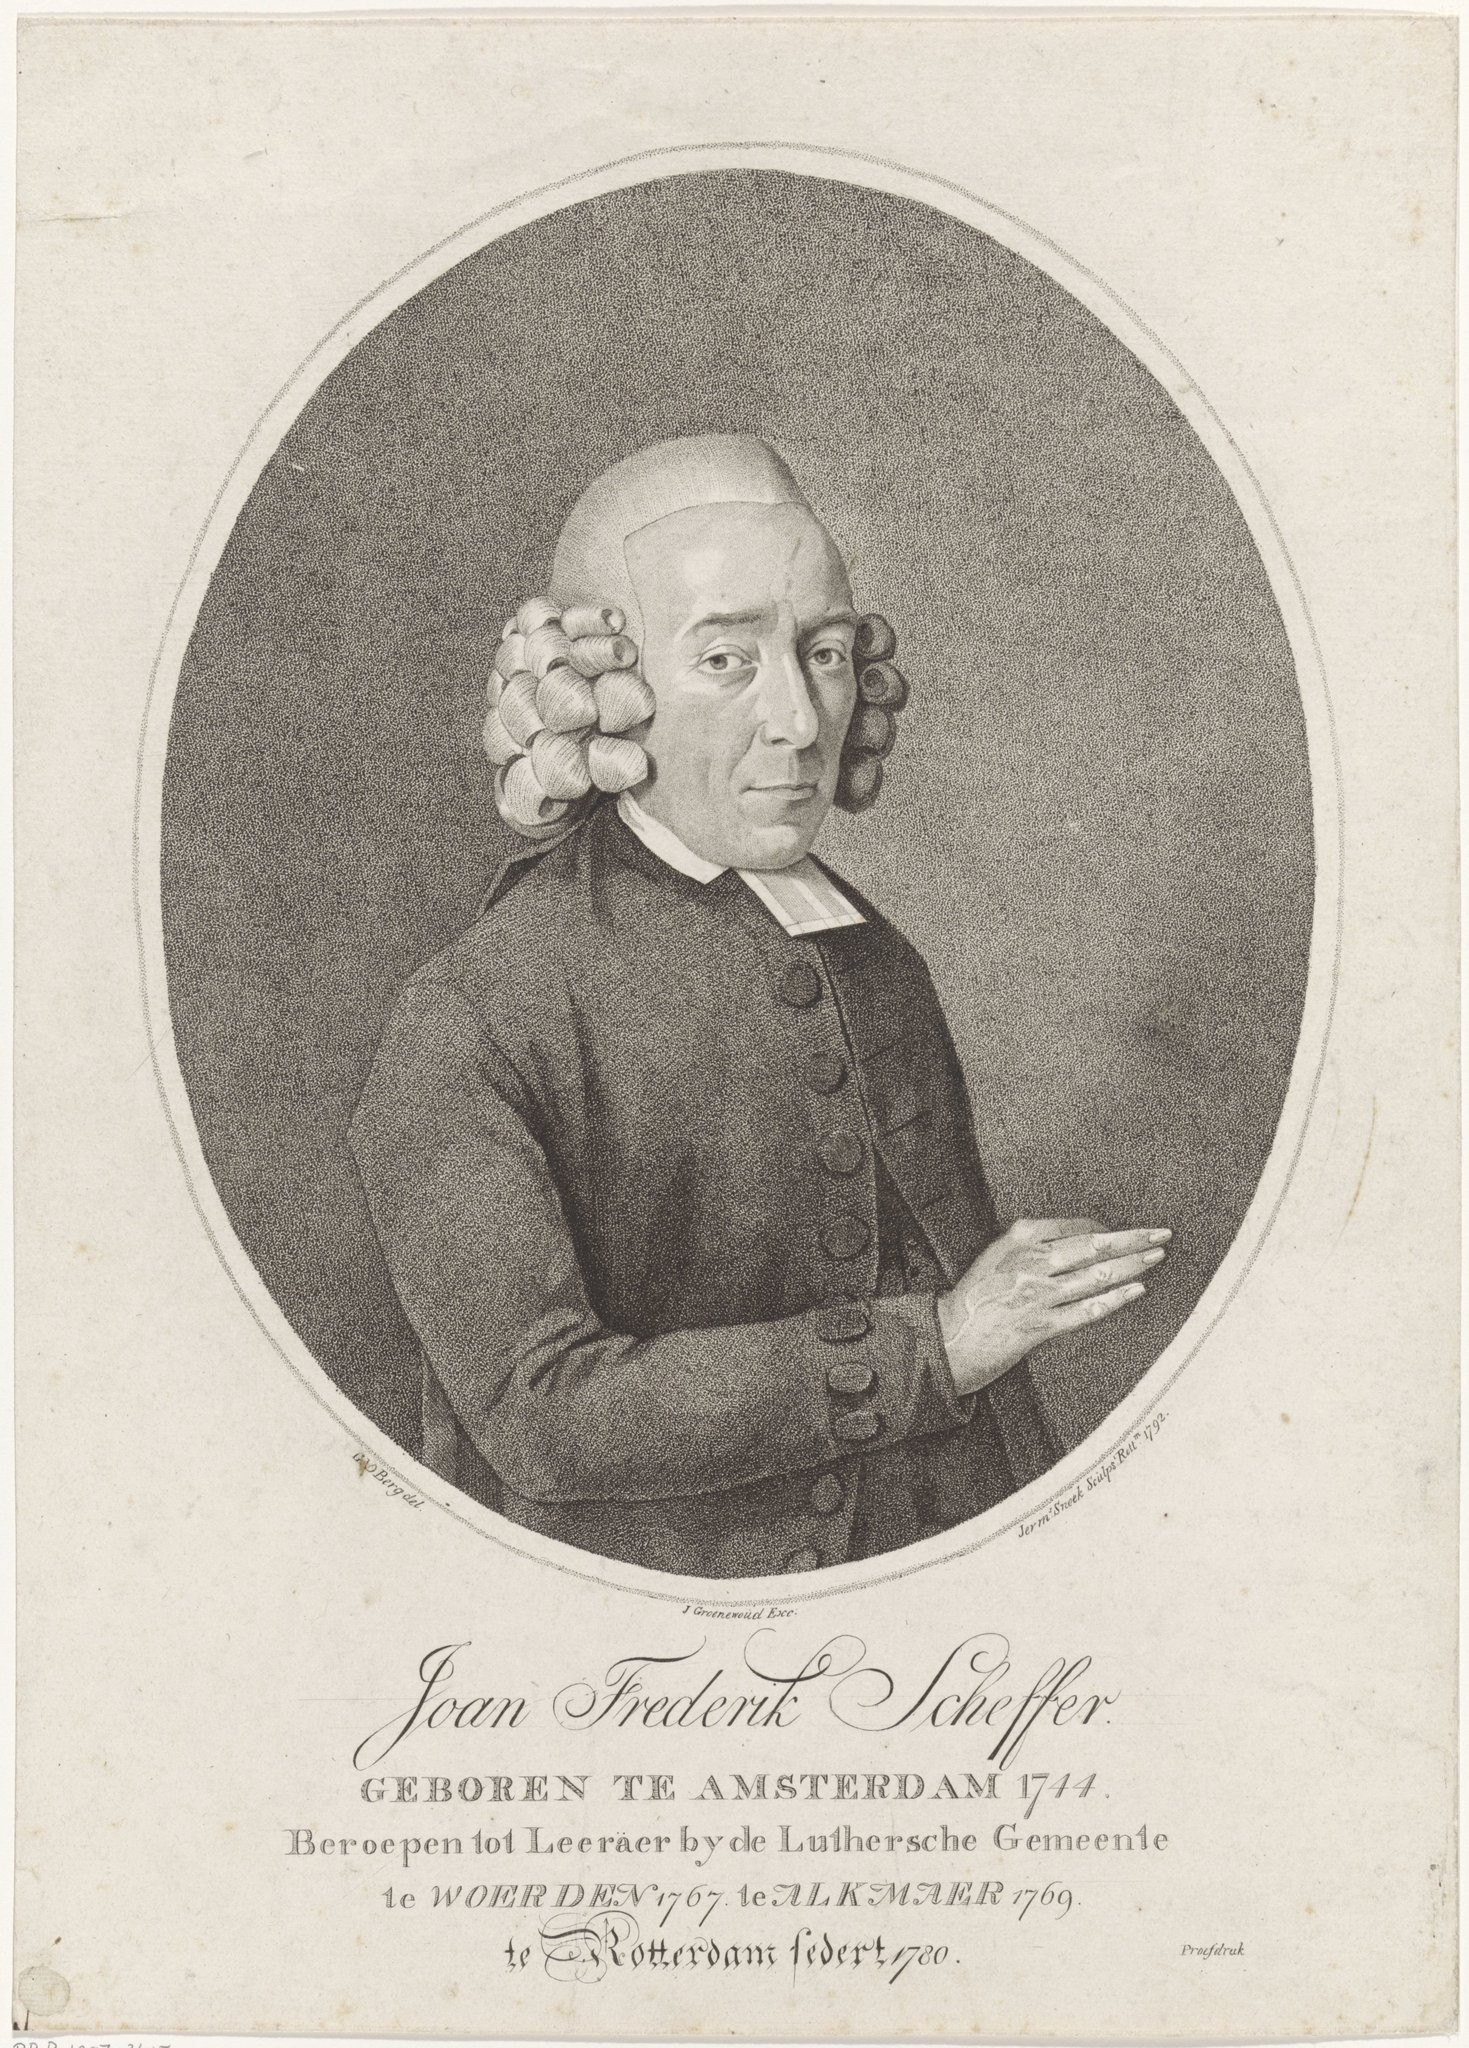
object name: print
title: Portret van Johan Frederik Scheffer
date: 1792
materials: paper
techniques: etching, engraving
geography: rotterdam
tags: rotterdam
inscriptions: collector's mark: Lugt 2228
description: Portret van Johan Frederik Scheffer, Luthers predikant te Rotterdam. Onder het portret staan zijn naam, geboortejaar en opeenvolgende aanstellingen.